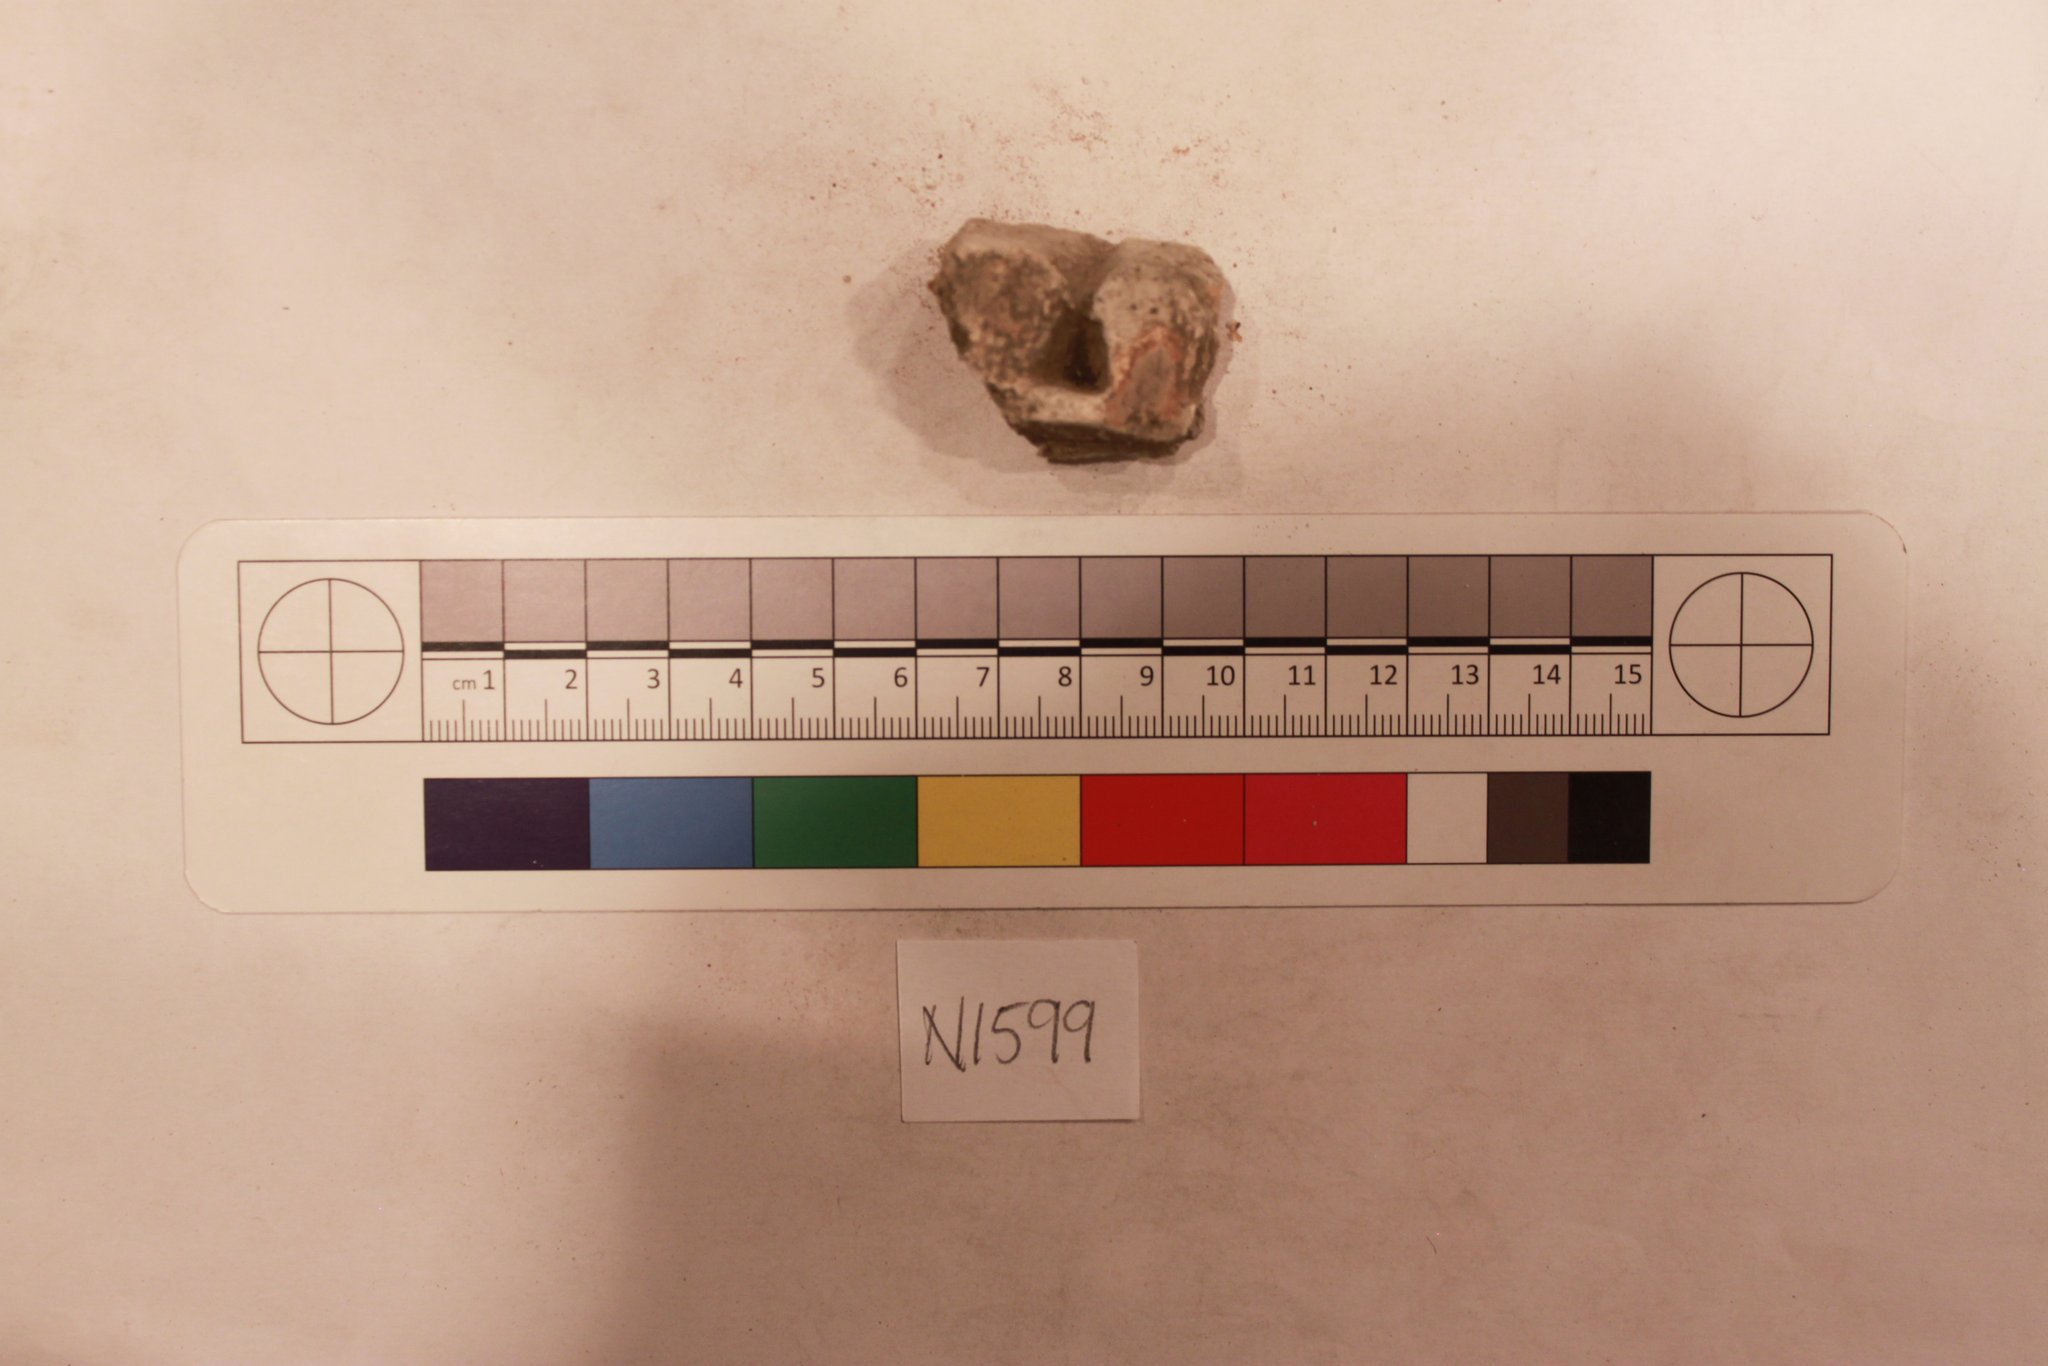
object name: fragment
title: Stucco Fragment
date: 701-1200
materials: plaster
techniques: carving, painting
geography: iran